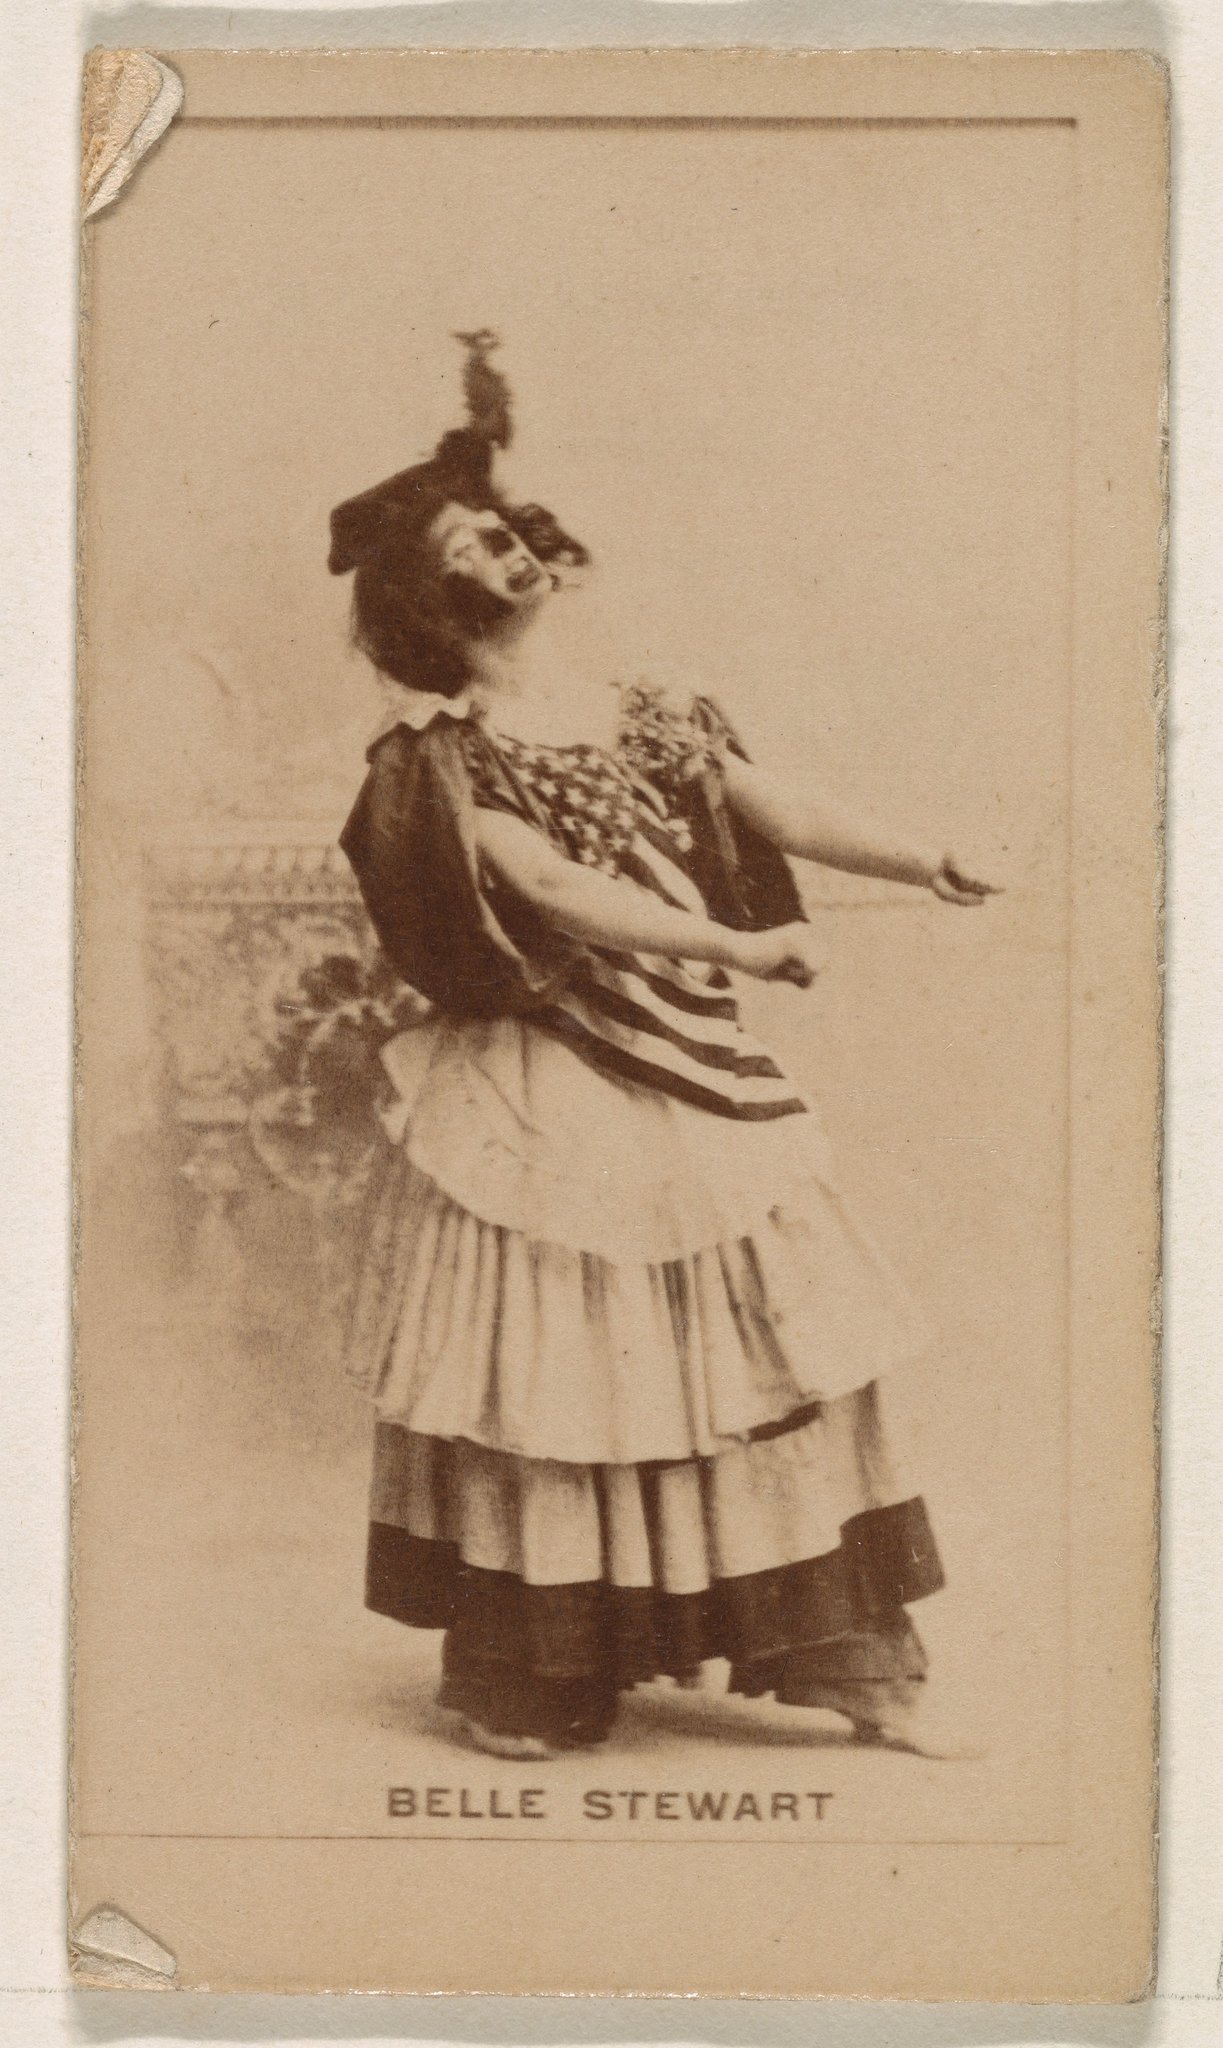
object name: photograph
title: Belle Stewart, from the Actresses series (N245) issued by Kinney Brothers to promote Sweet Caporal Cigarettes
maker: kinney brothers tobacco company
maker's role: publisher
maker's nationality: american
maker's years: 1869-2011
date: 1890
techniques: albumen silver print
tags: portraits,women,actresses